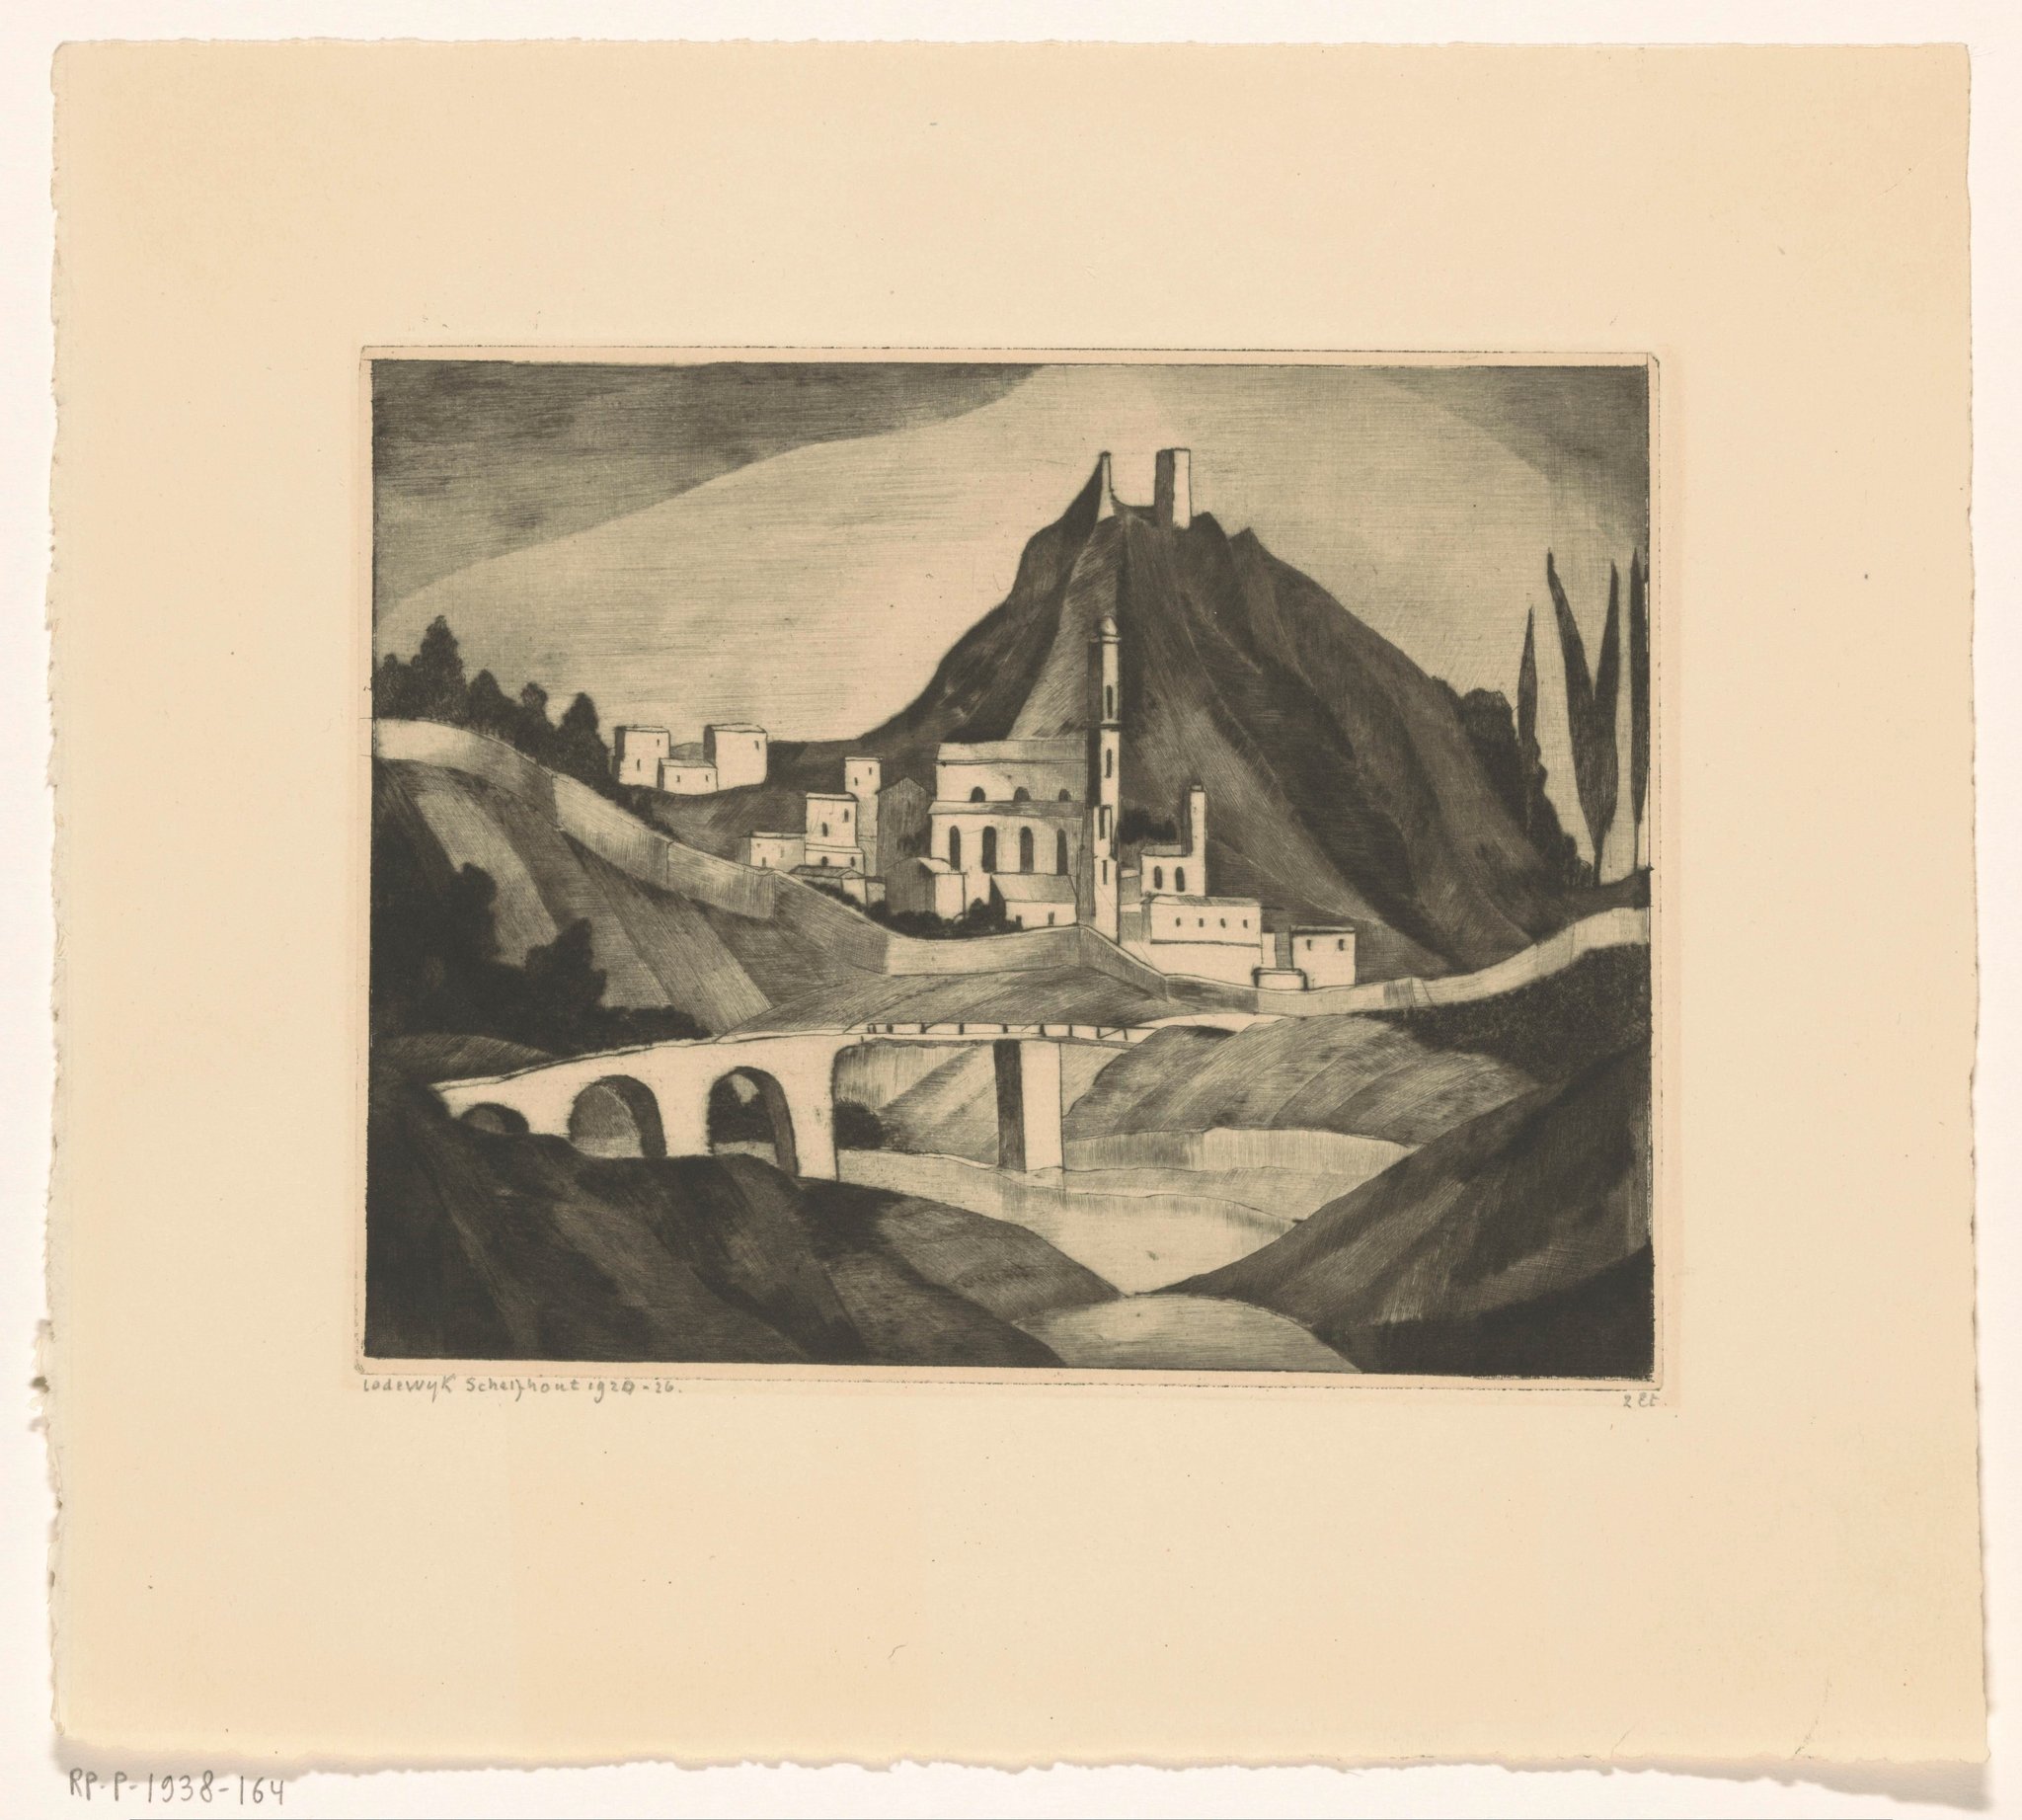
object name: print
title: Corte I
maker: lodewijk schelfhout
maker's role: draughtsman, print maker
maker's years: 1881-1943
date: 1920-1926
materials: paper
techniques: drypoint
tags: city-view, and landscape with man-made constructions, bridge, mountains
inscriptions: collector's mark: Lugt 2228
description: De plaats Corte, gelegen in het midden van Corsica. Op de voorgrond een brug over een rivier. Op de achtergrond, op de top van een berg, de burcht van Corte.